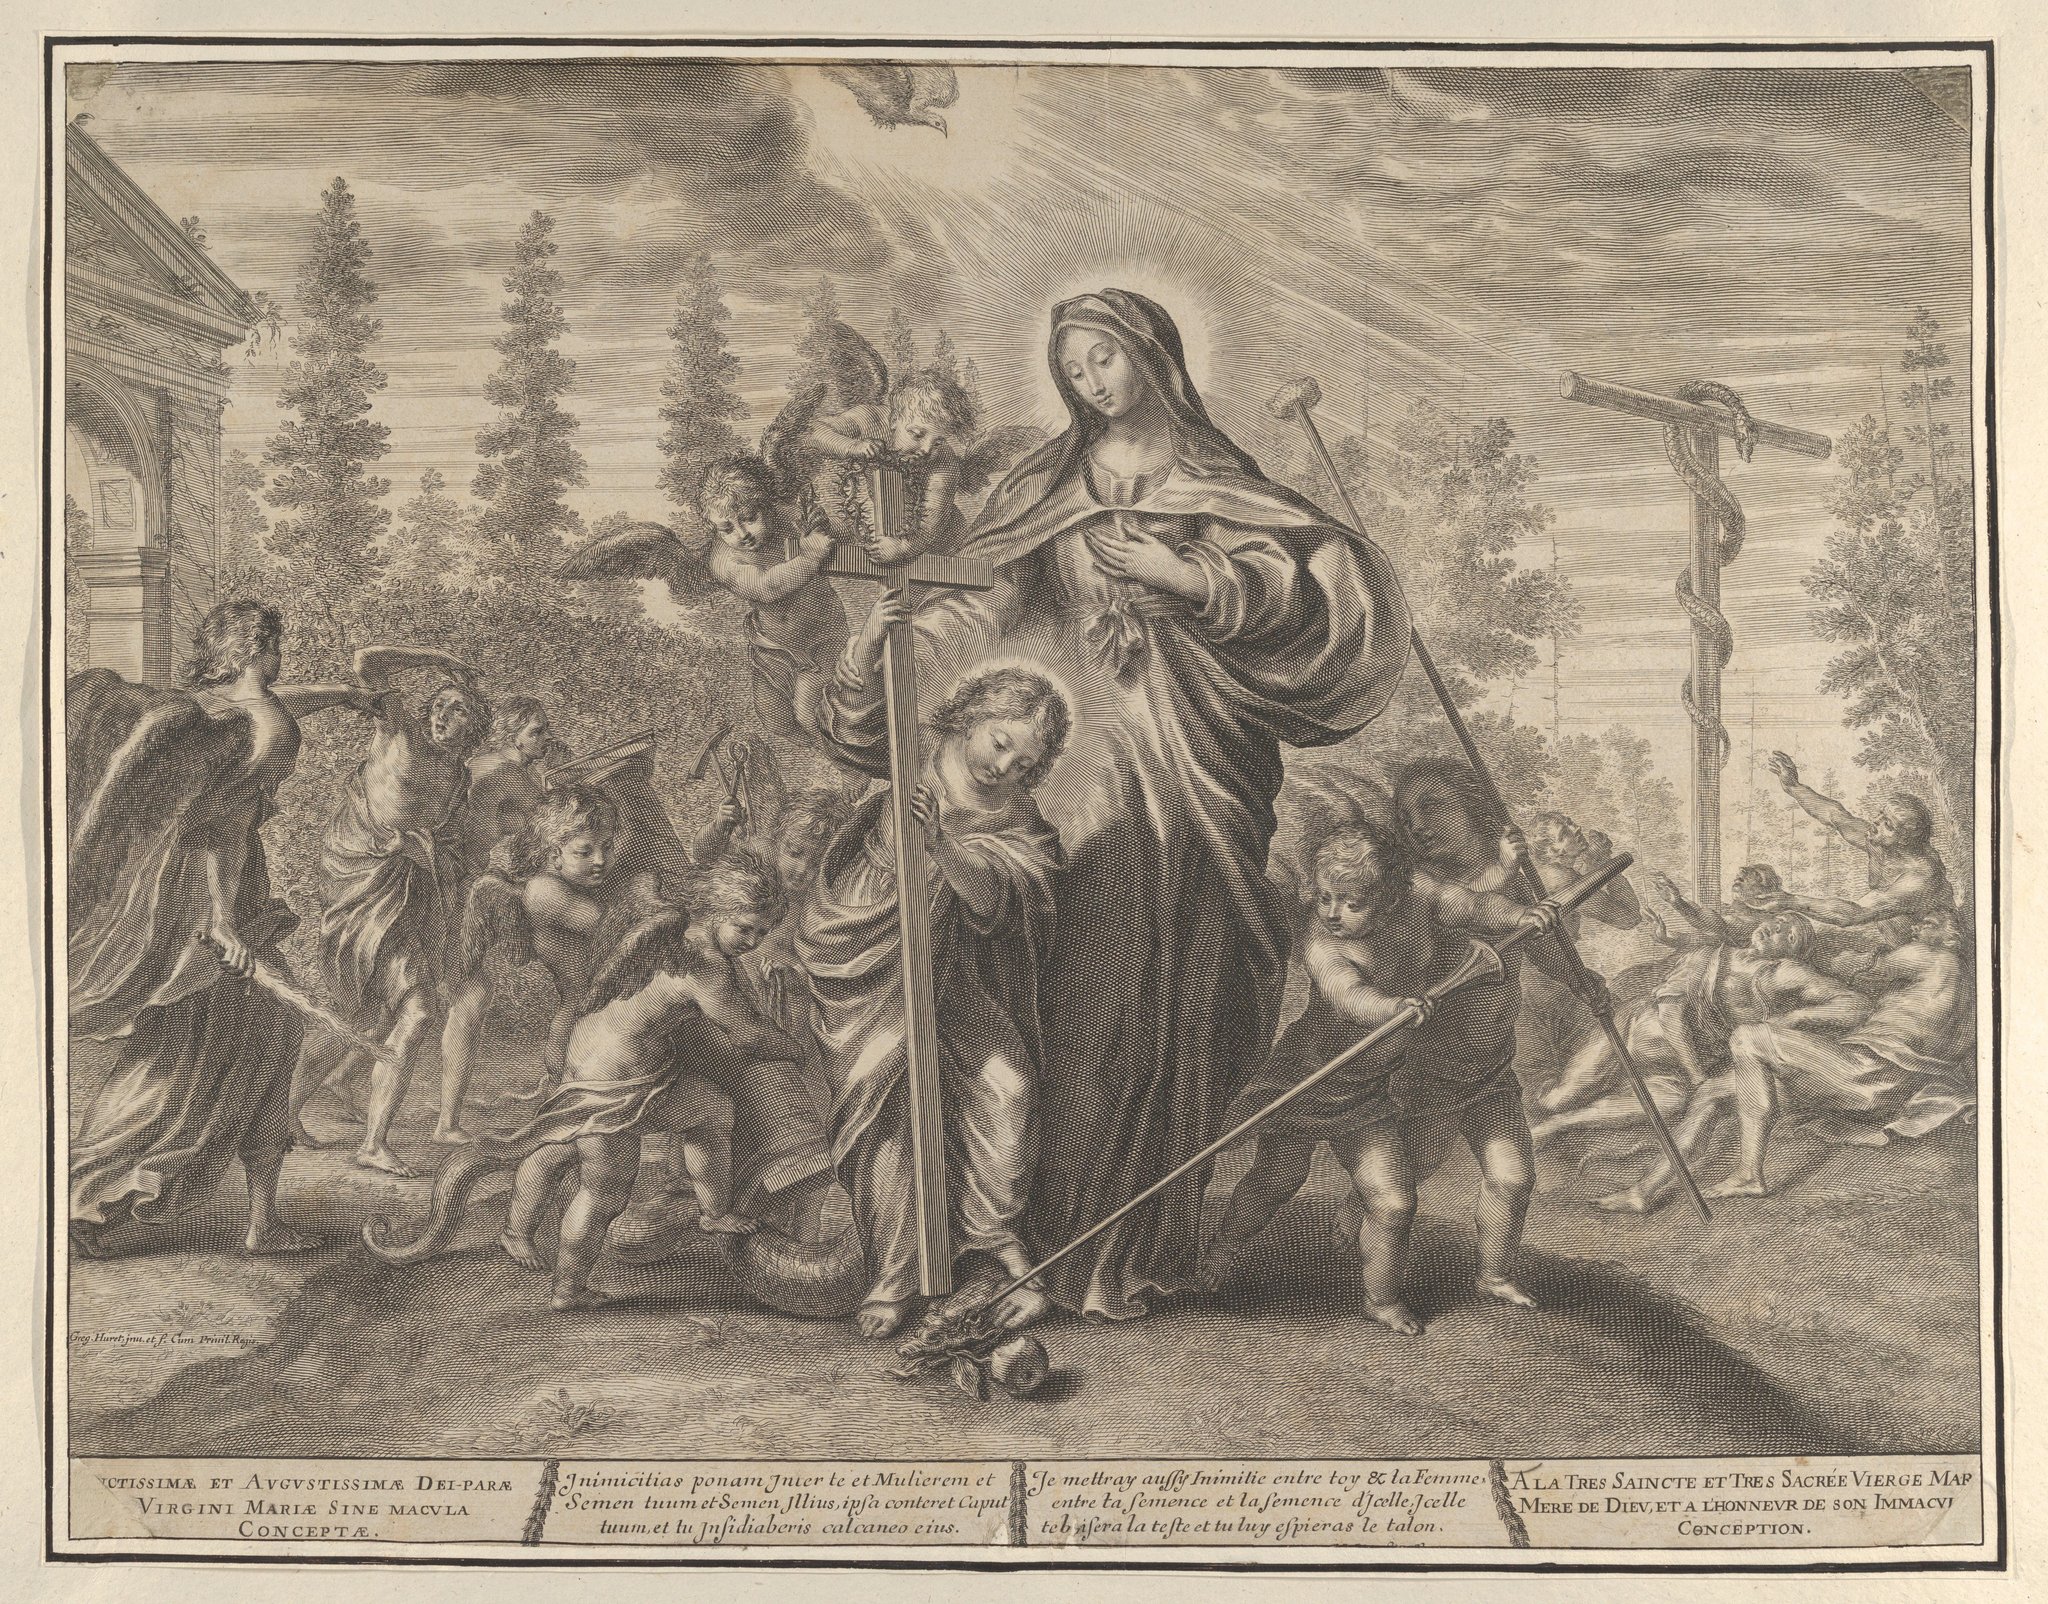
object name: print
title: Allegory of the Immaculate Conception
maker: grégoire huret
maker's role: artist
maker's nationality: french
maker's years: 1606-1670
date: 1601-1700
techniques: engraving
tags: angels,virgin mary,cross